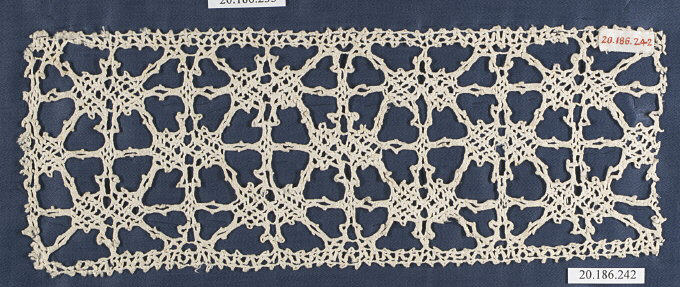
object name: insertion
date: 1501-1600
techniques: lace